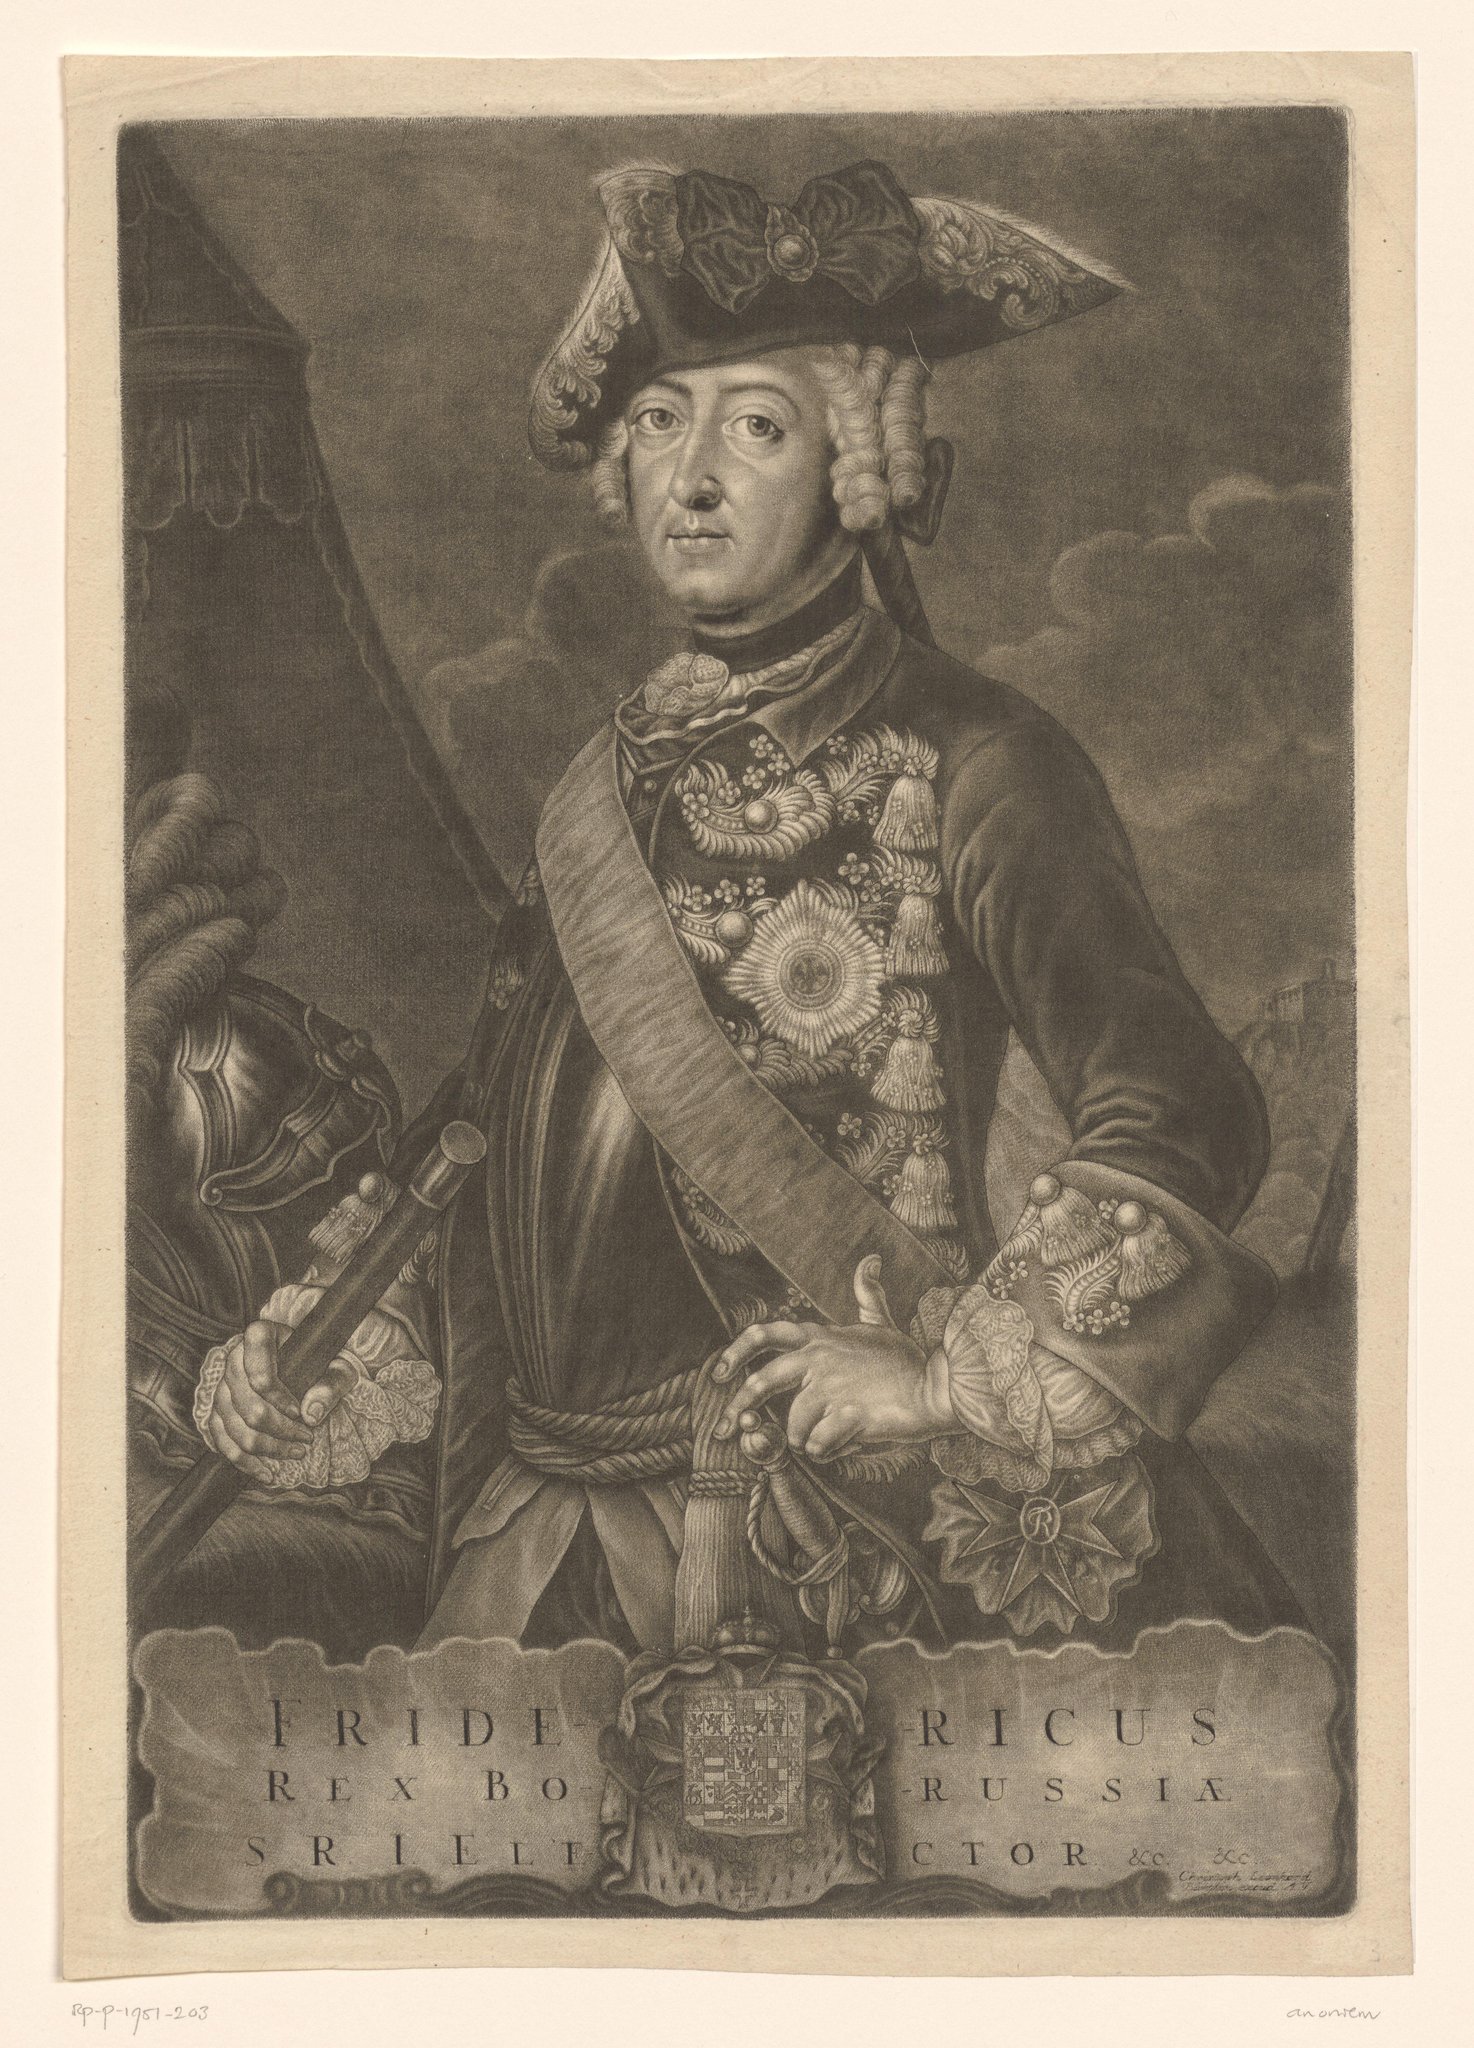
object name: print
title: Portret van Frederik de Grote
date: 1740-1772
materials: paper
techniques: engraving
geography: augsburg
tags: berlin, frederick ii (king of prussia), helmet, historical persons, (military) uniforms, armorial bearing, heraldry